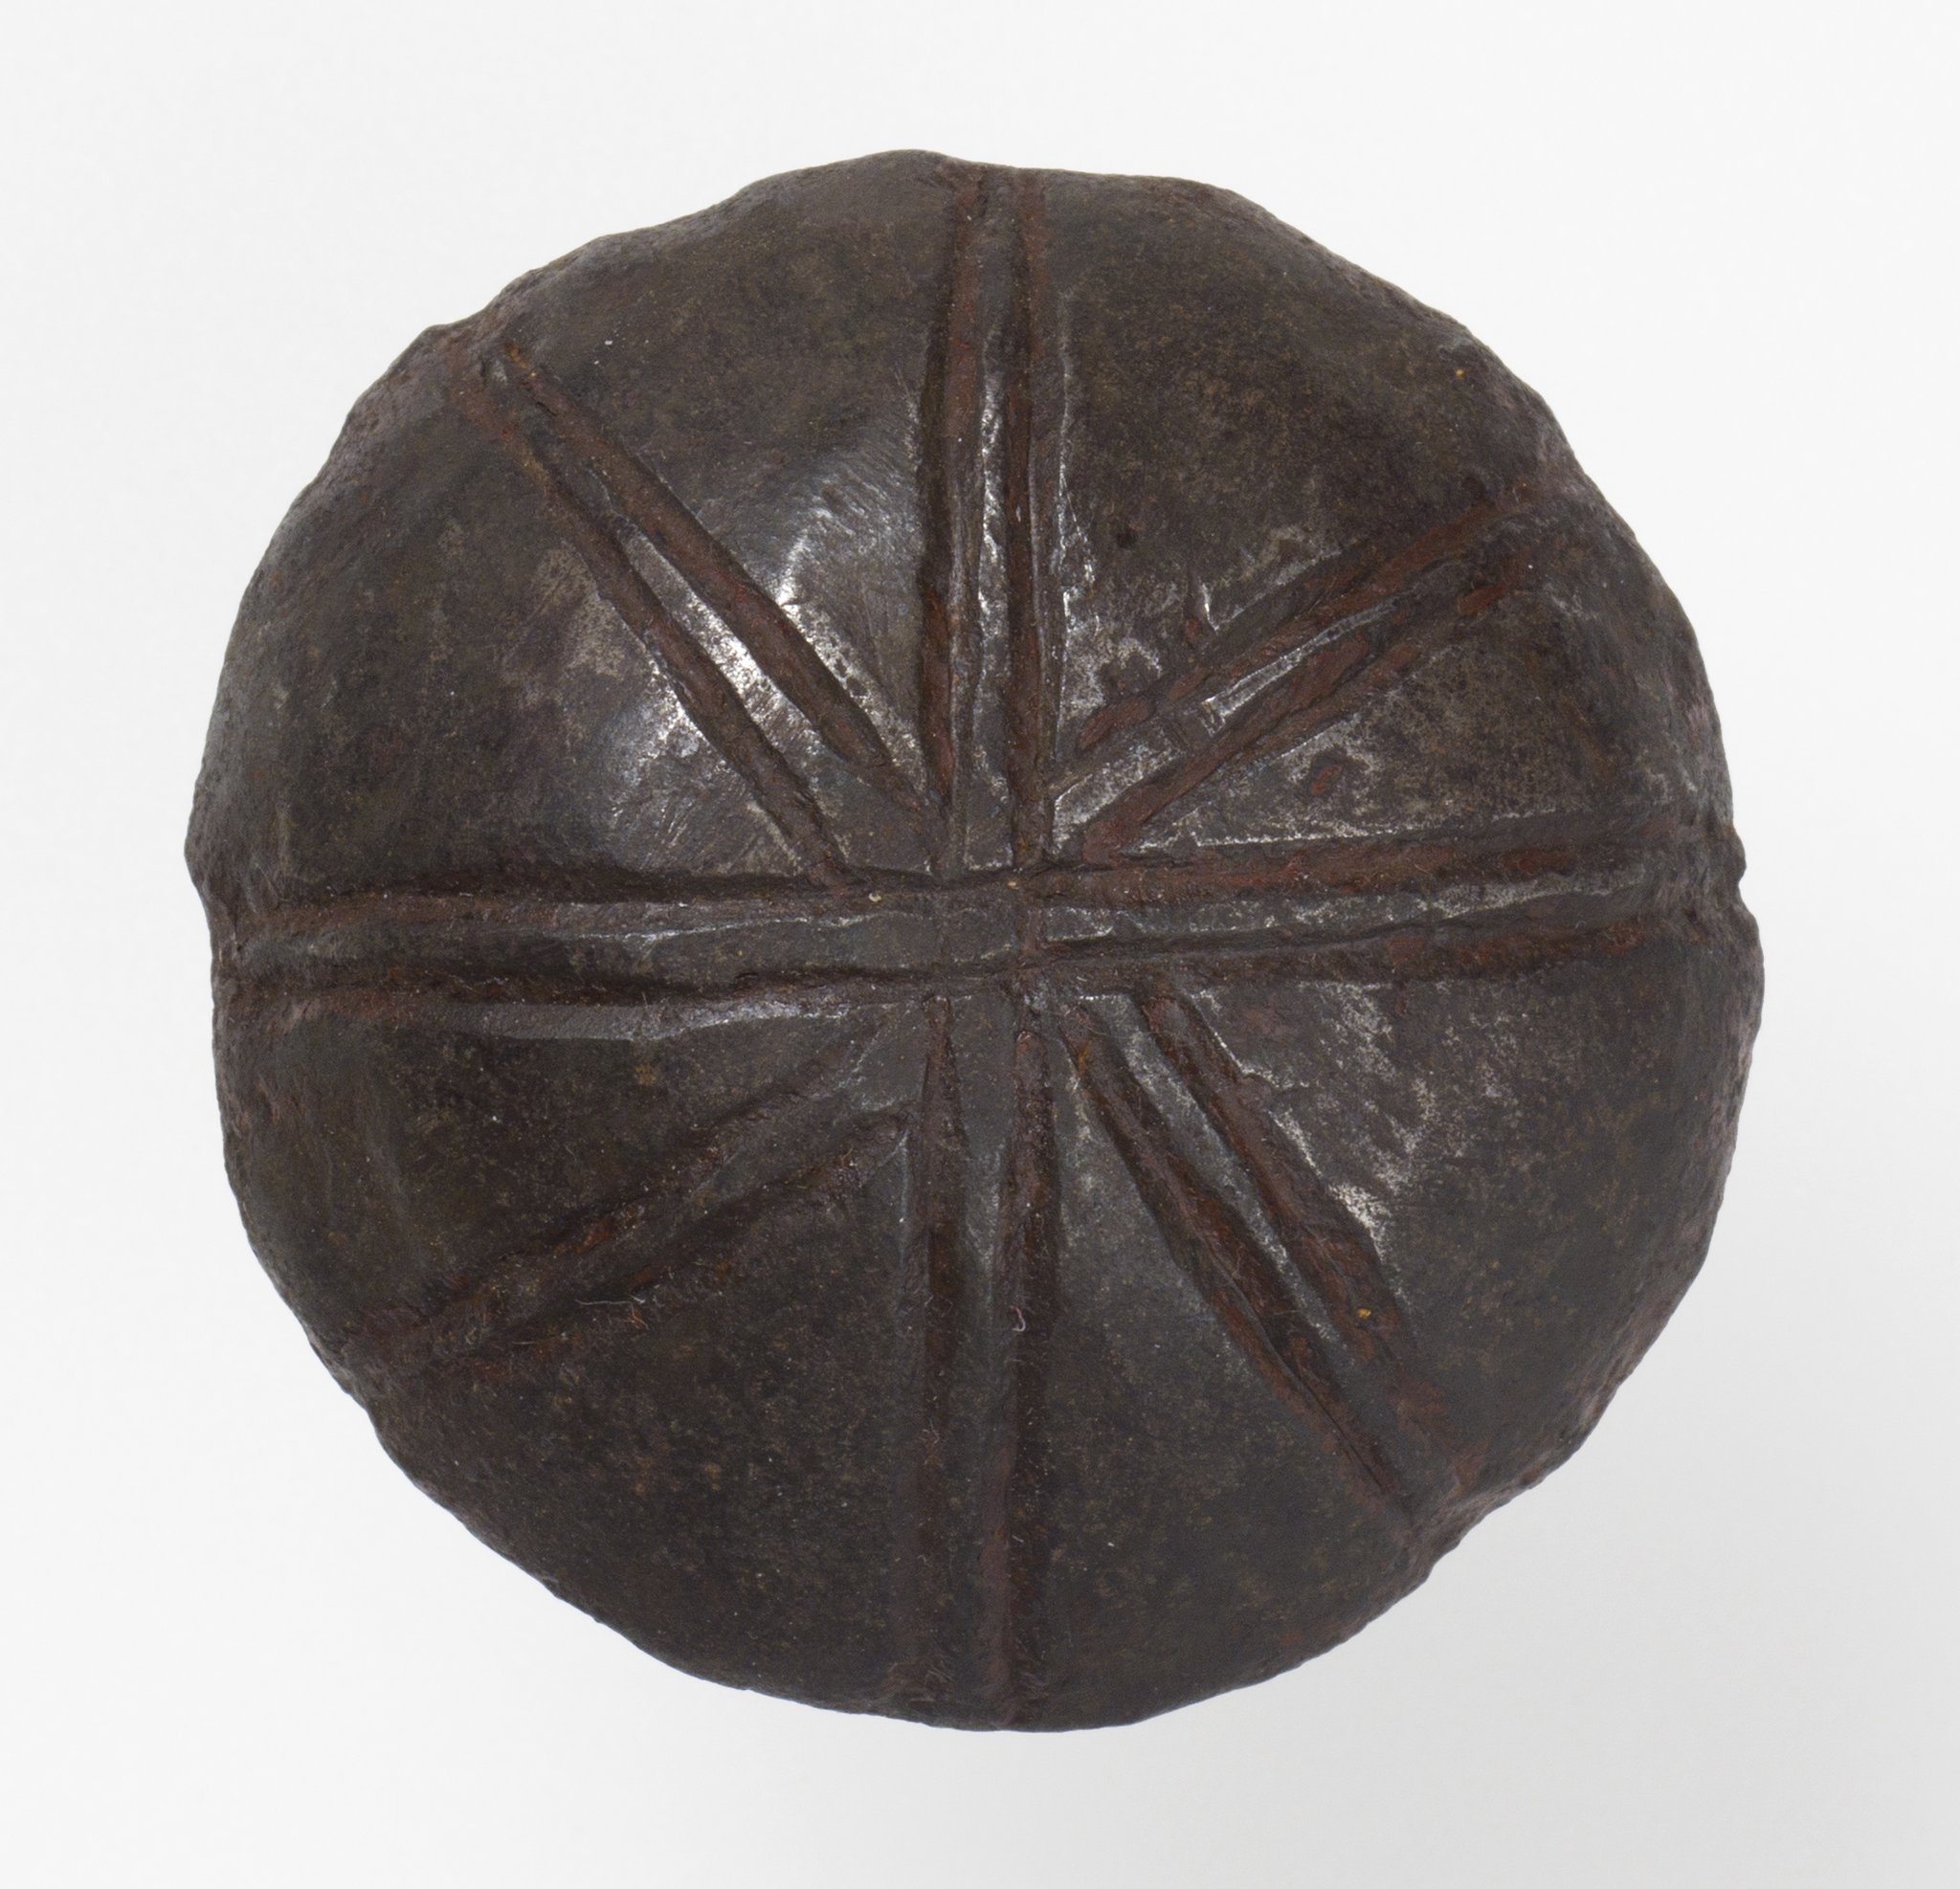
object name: nail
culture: european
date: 1401-1600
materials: iron